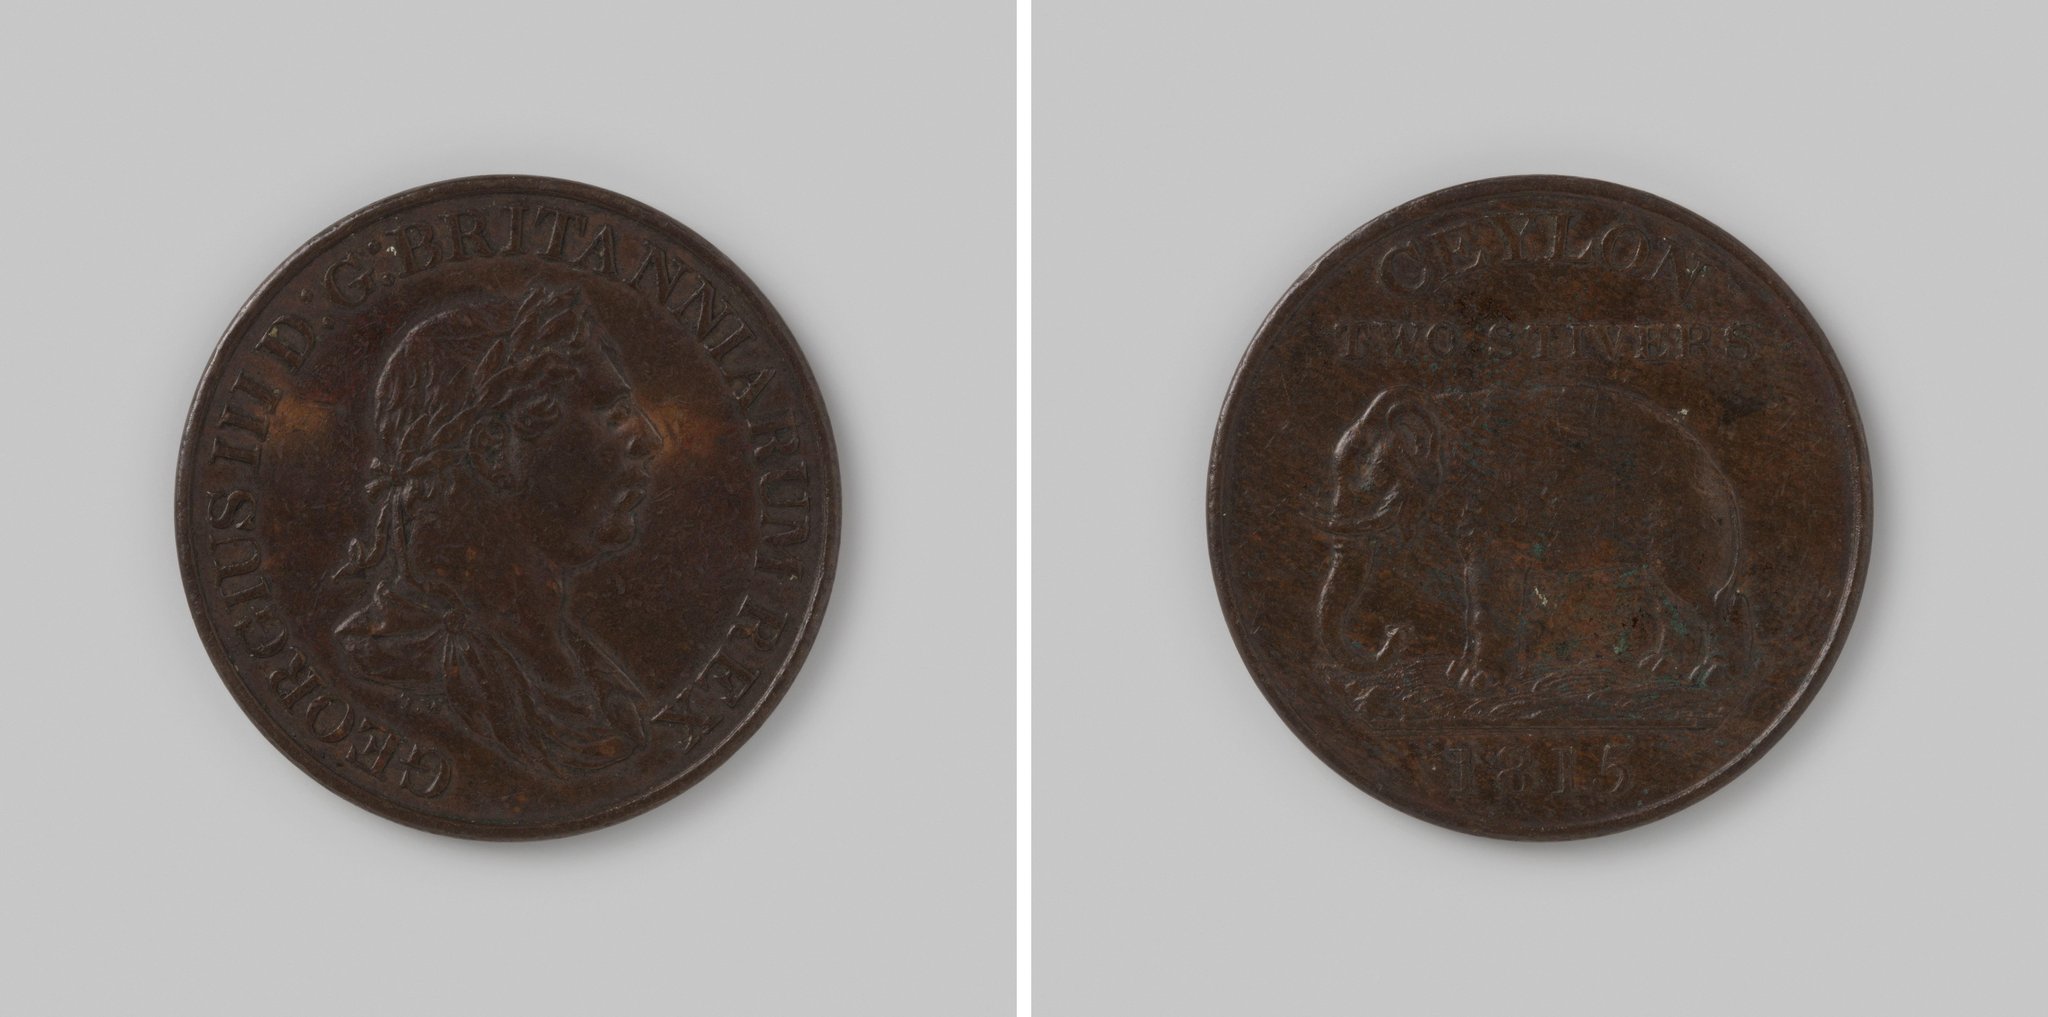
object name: coin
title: Sri Lanka, Ceylon, 2 stivers op naam van koning George III,1815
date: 1815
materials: copper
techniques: striking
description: Koperen munt. Voorzijde: gelauwerd borstbeeld van de koning naar rechts. Keerzijde: lopende olifant naar links. Daarboven waarde-aanduiding: two stivers. In afsnede jaartal onderaan. Geslagen in Engeland.